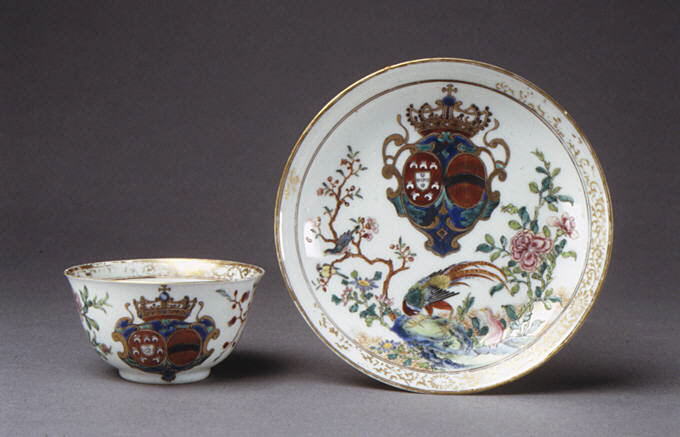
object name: teabowl and saucer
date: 1742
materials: hard paste porcelain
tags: birds,flowers,coat of arms